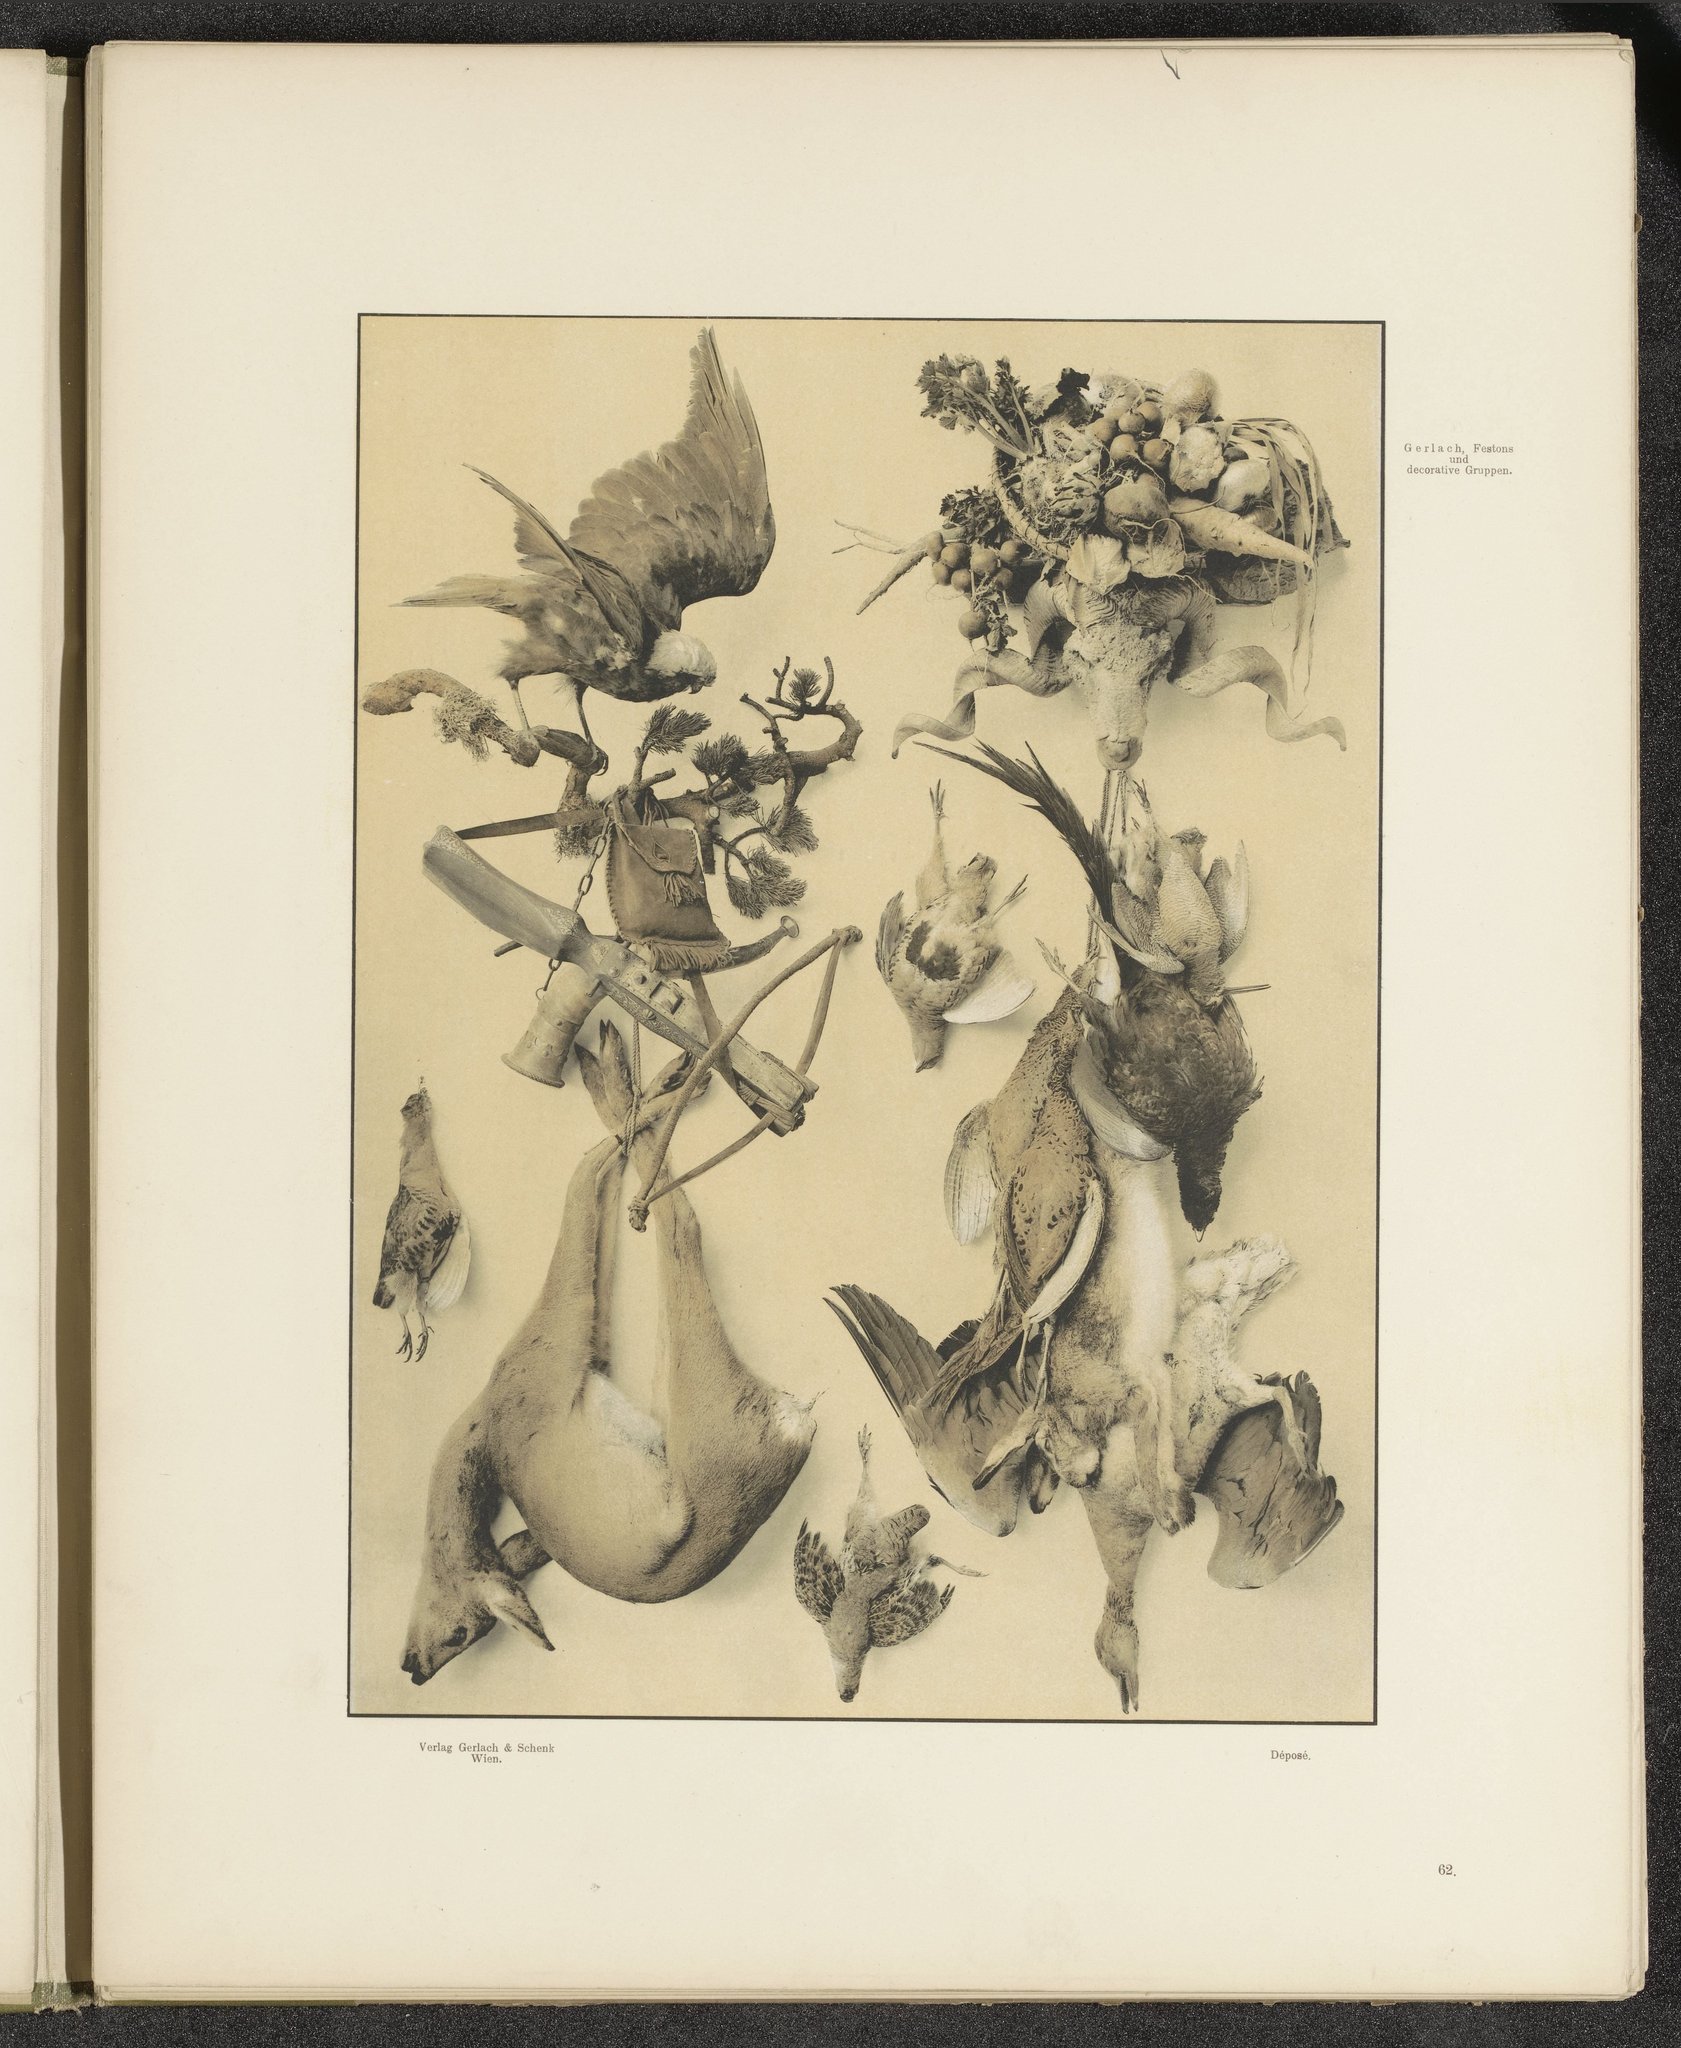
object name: photomechanical print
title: Festoengroepen met een ree, een haas en gevogelte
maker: Anonymous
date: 1887-1897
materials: paper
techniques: photograph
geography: austria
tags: hoofed animals: deer, birds, rodents: hare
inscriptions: number: ‘62.’